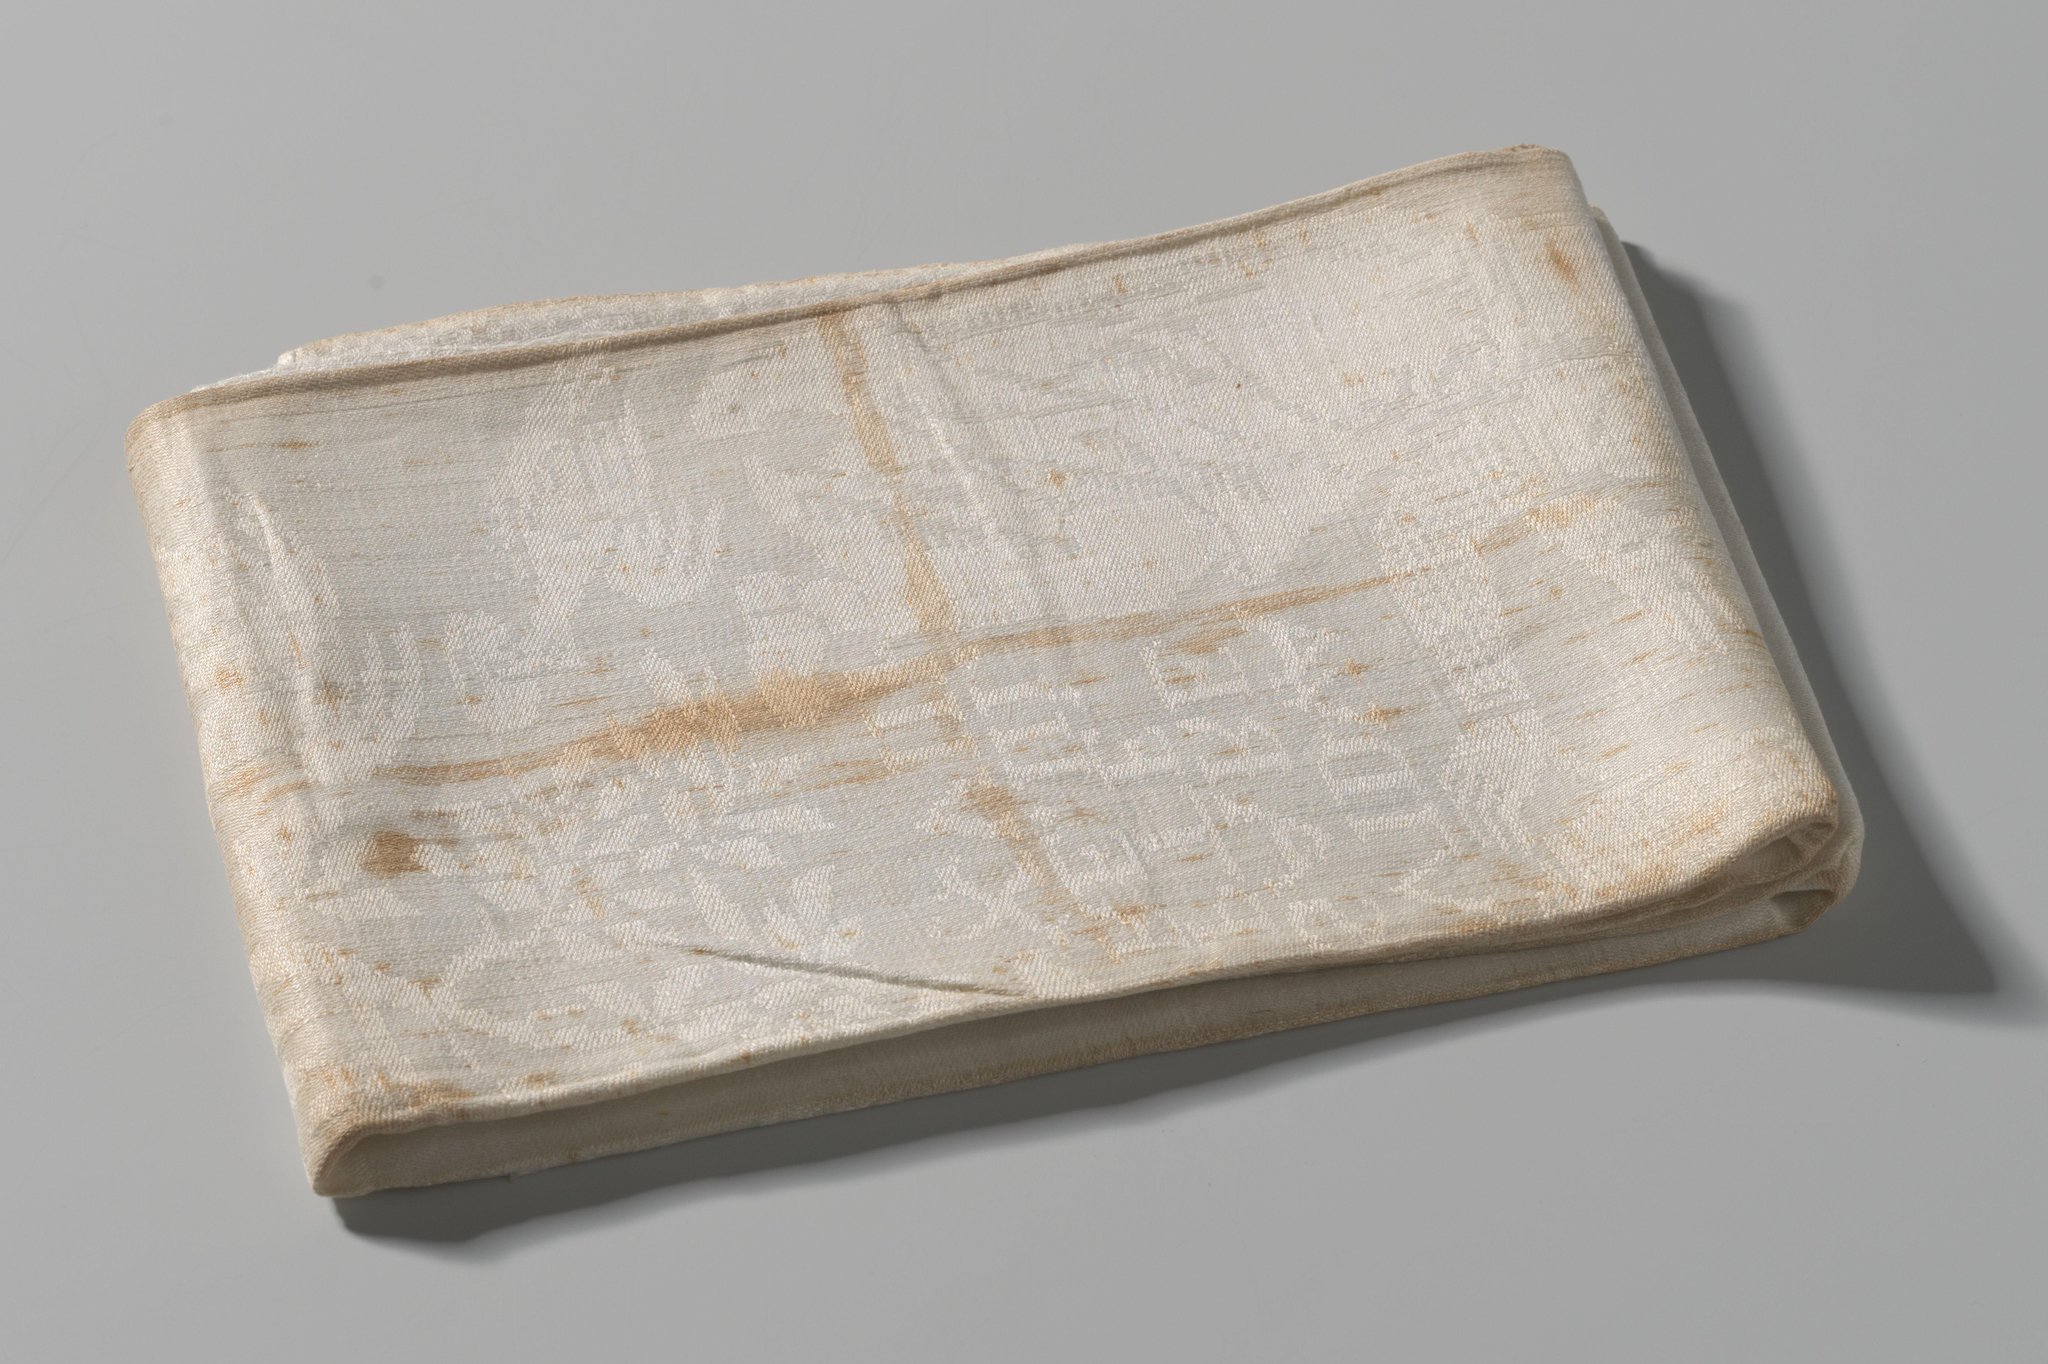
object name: napkin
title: Servet met de geschiedenis van de profeet Elia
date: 1600-1649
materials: linen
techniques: damask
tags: story of elijah (elias)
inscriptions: mark: ‘IVDH 6’